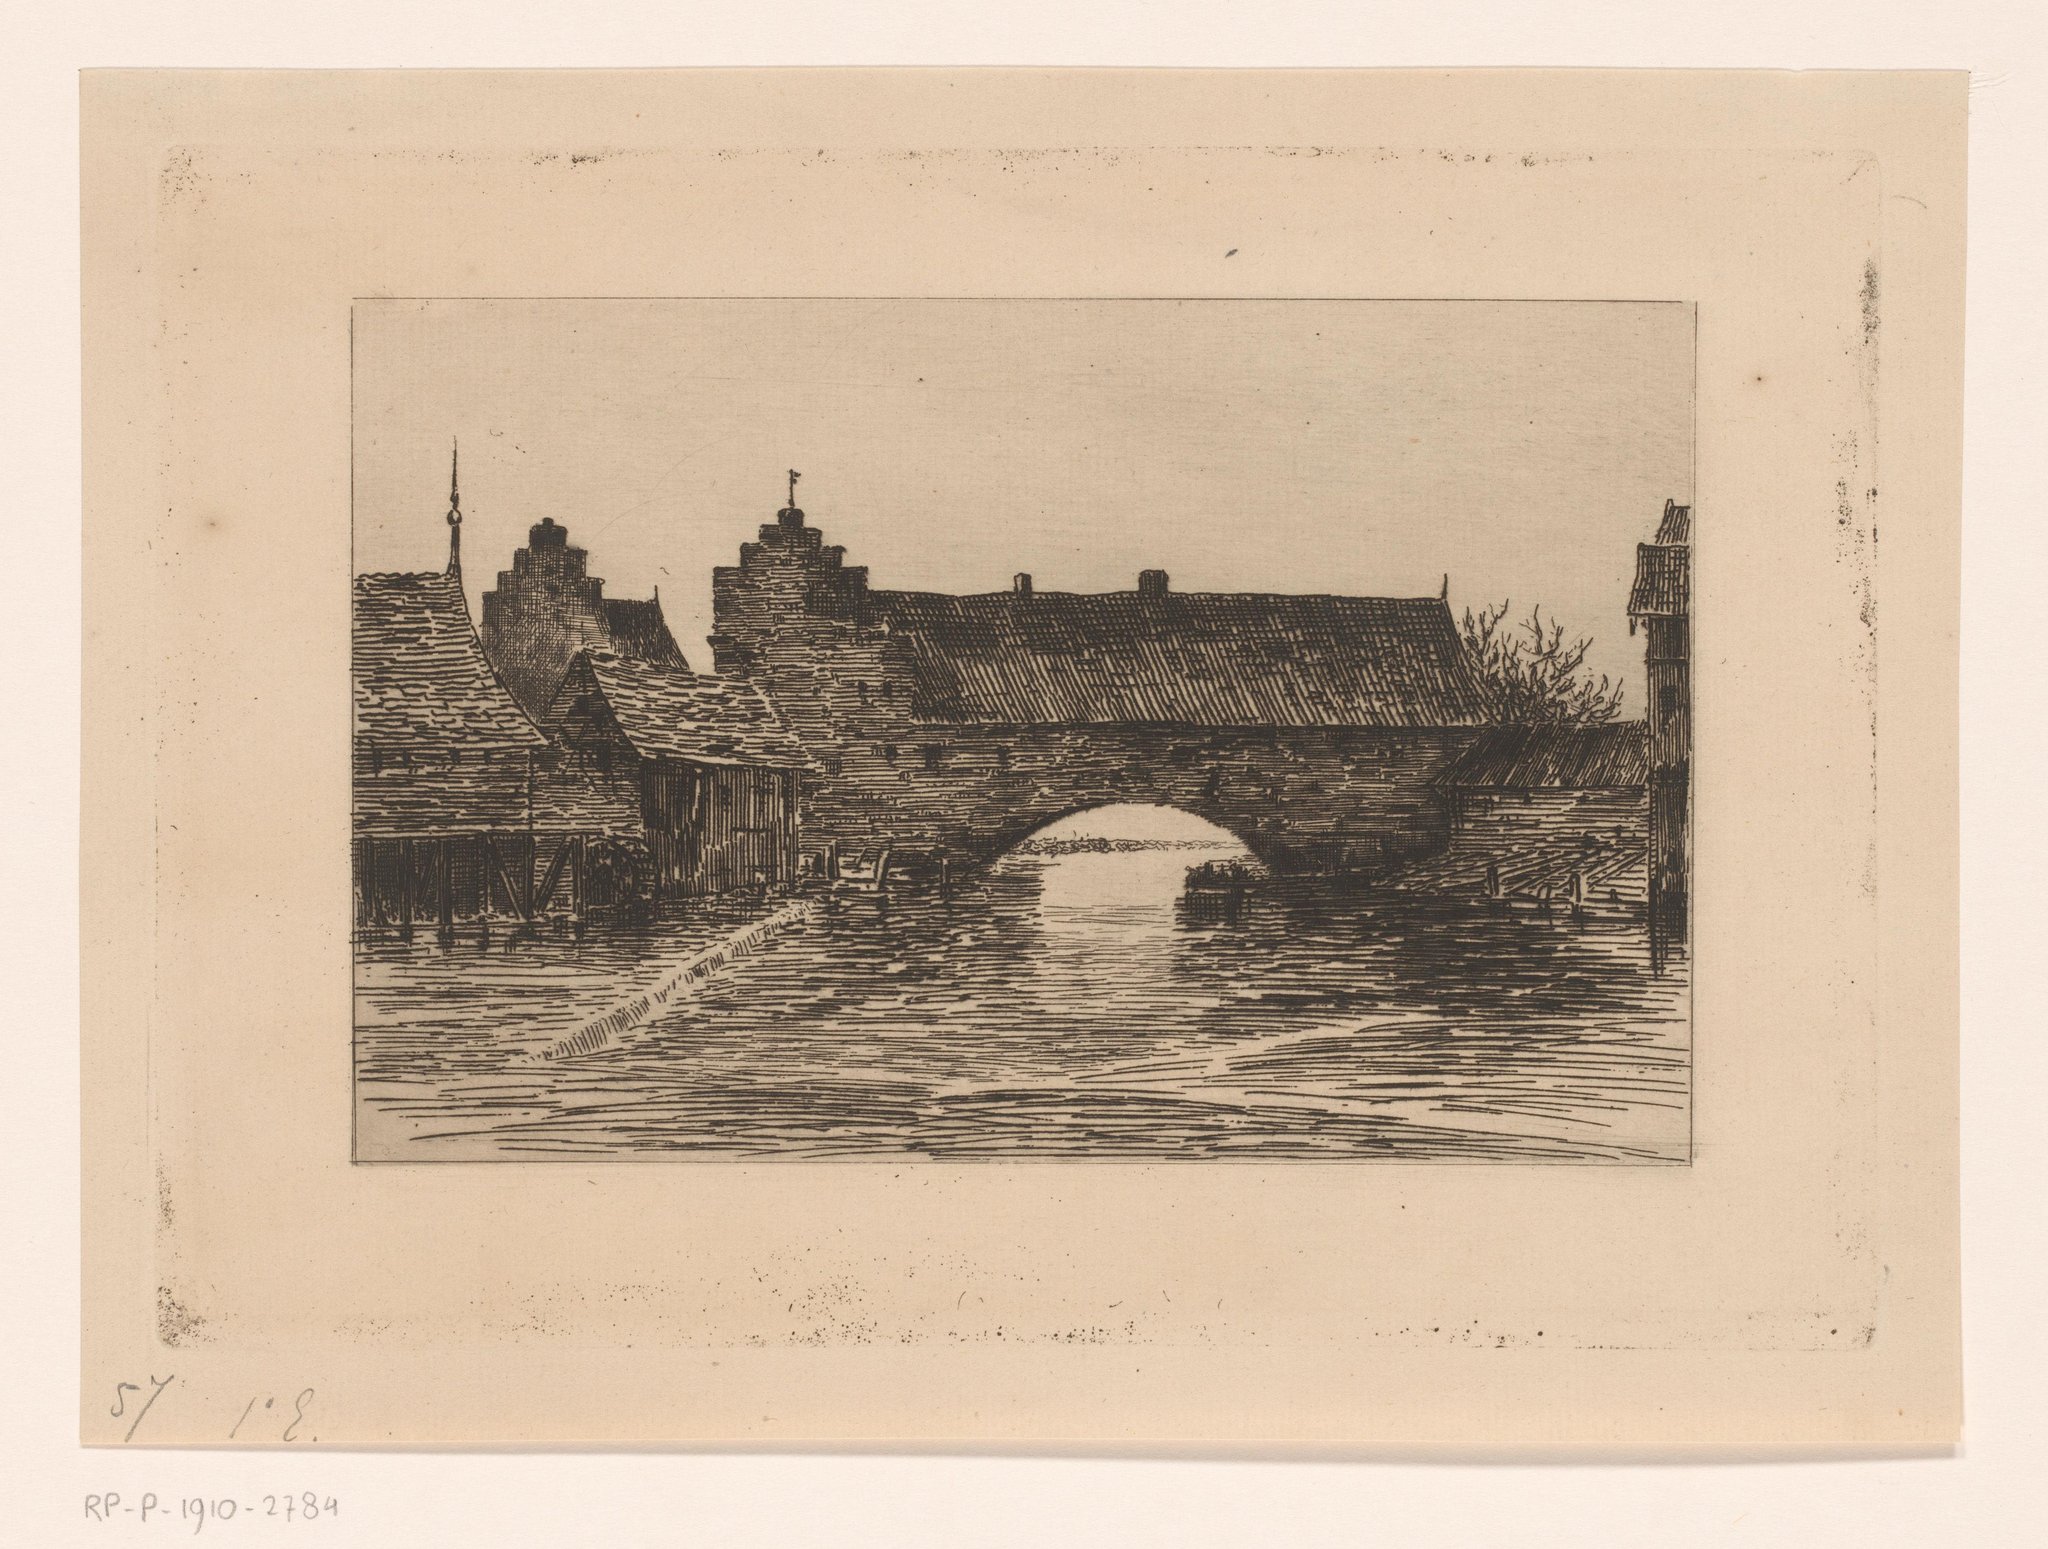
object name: print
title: La Pegnitz et les anciens murs à Nurnberg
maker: carel nicolaas storm van s-gravesande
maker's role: draughtsman, print maker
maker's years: 1841-1924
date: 1873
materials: paper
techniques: etching, intaglio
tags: bridge in city with structures, i.e. shops, houses, e.g. ponte vecchio in florence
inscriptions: collector's mark: Lugt 2228